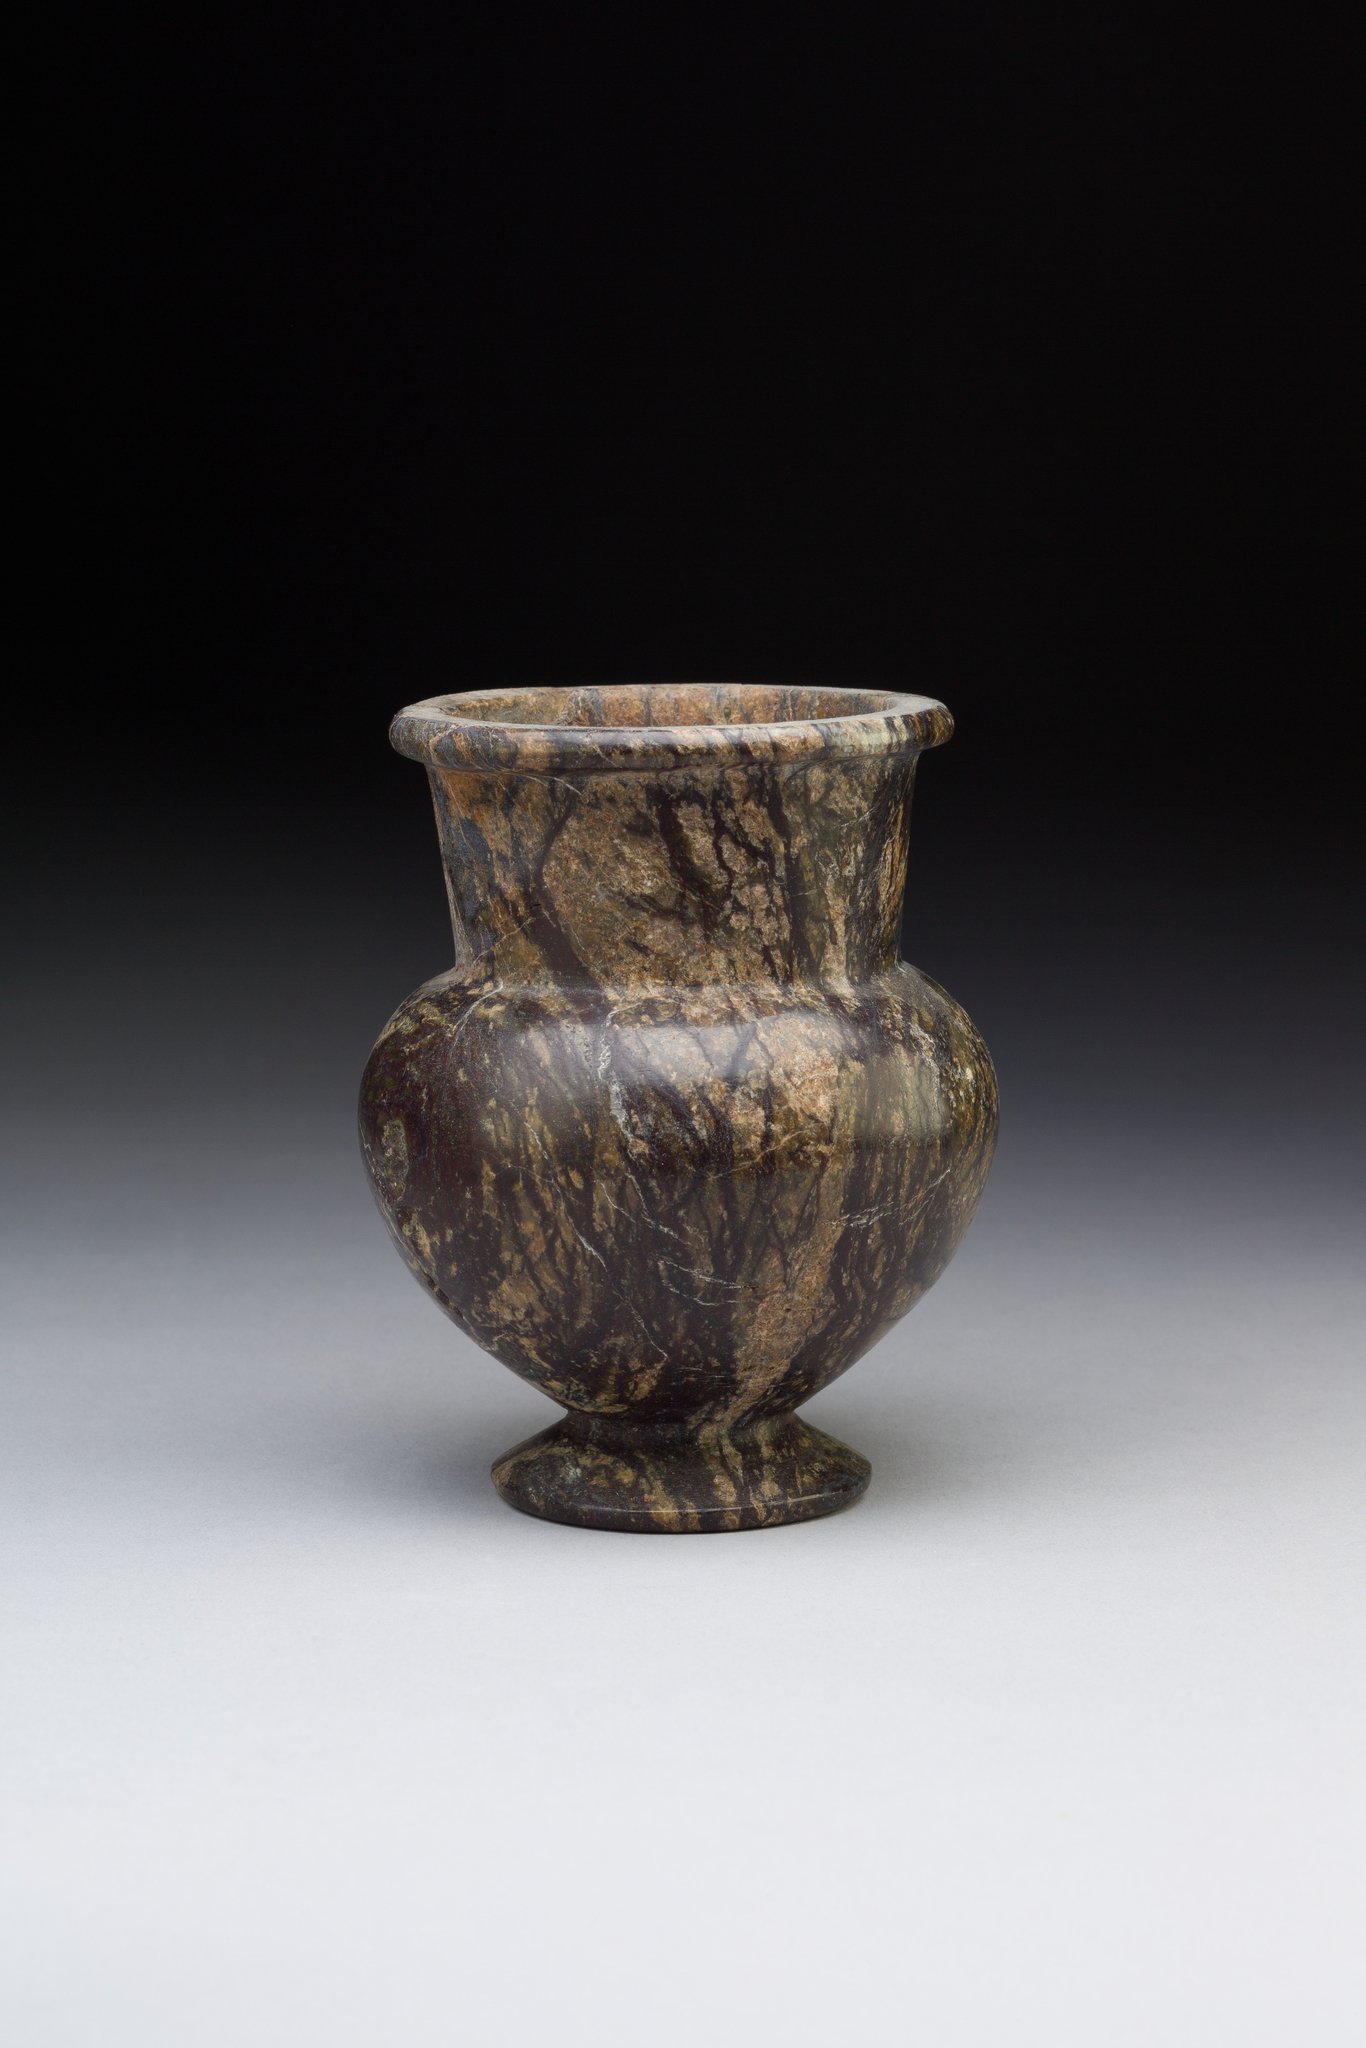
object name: jar, cosmetic, amenemhat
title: Unguent Jar from Neferkhawet's Tomb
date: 1504-1447 BCE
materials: stone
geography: egypt